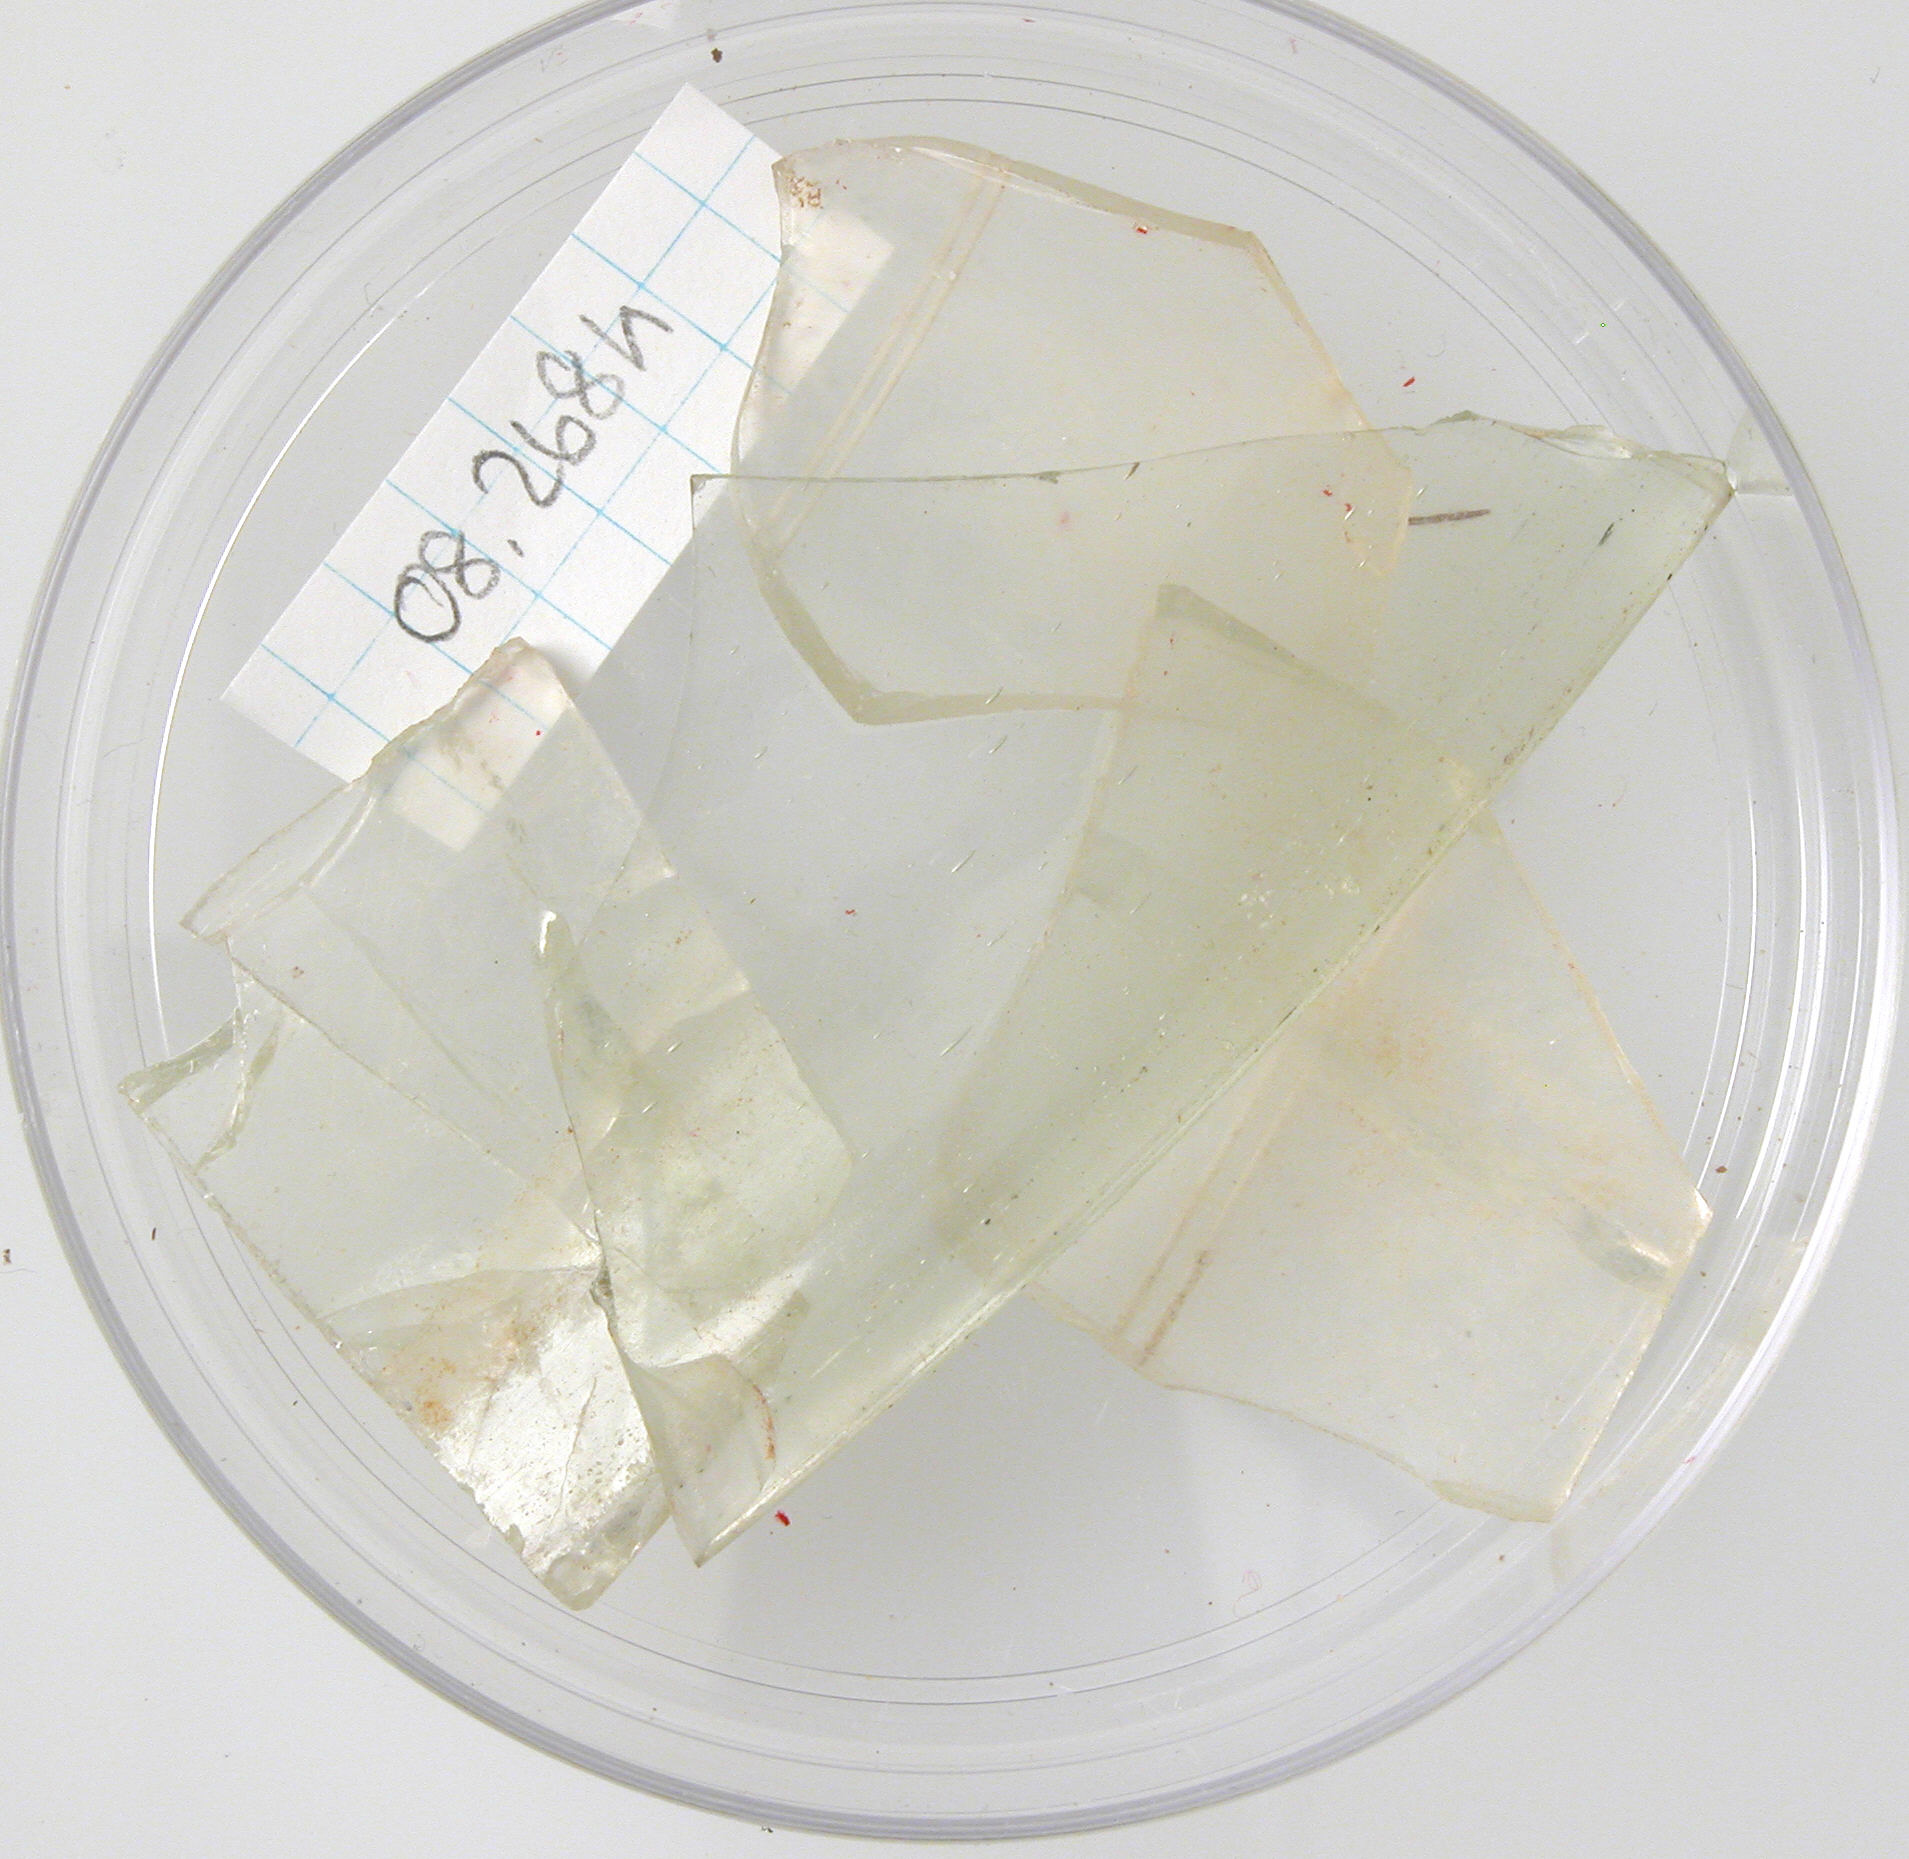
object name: fragment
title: Glass Fragments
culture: coptic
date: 301-433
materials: glass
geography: egypt